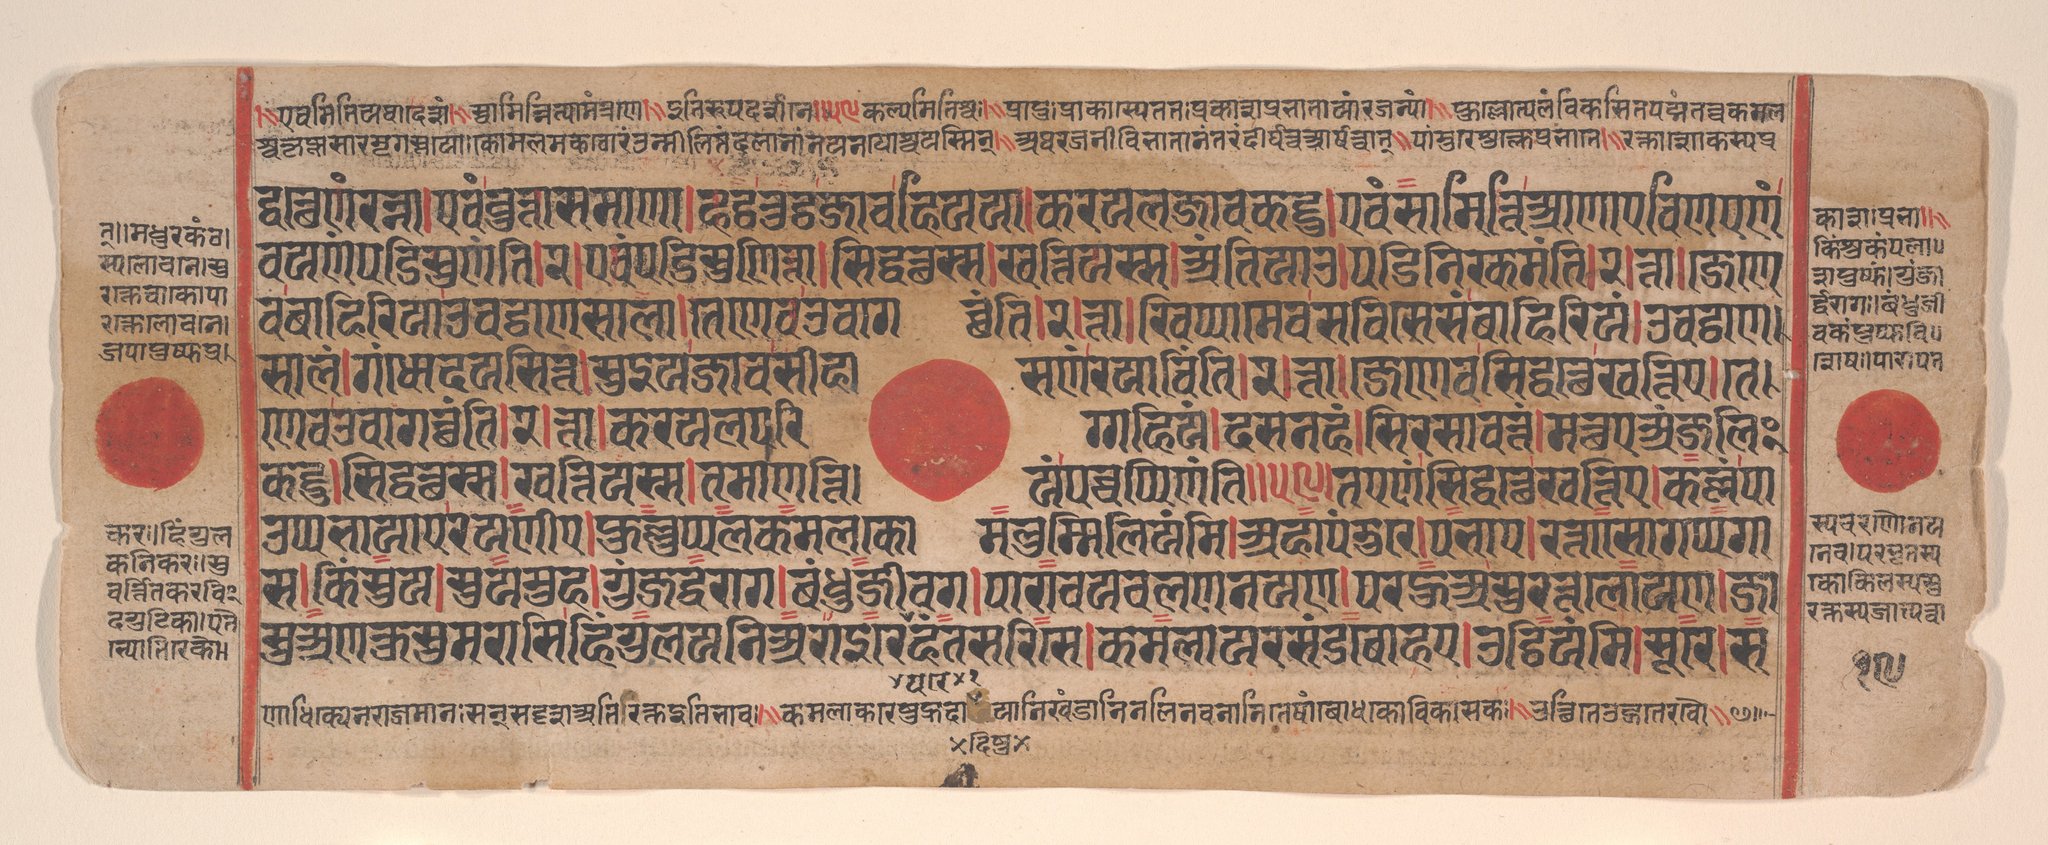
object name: folio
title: Leaf from a Kalpa Sutra (Jain Book of Rituals)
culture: indian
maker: bhadrabahu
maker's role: artist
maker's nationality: indian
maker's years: 356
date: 1401-1500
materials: gold, ink, paper, watercolor